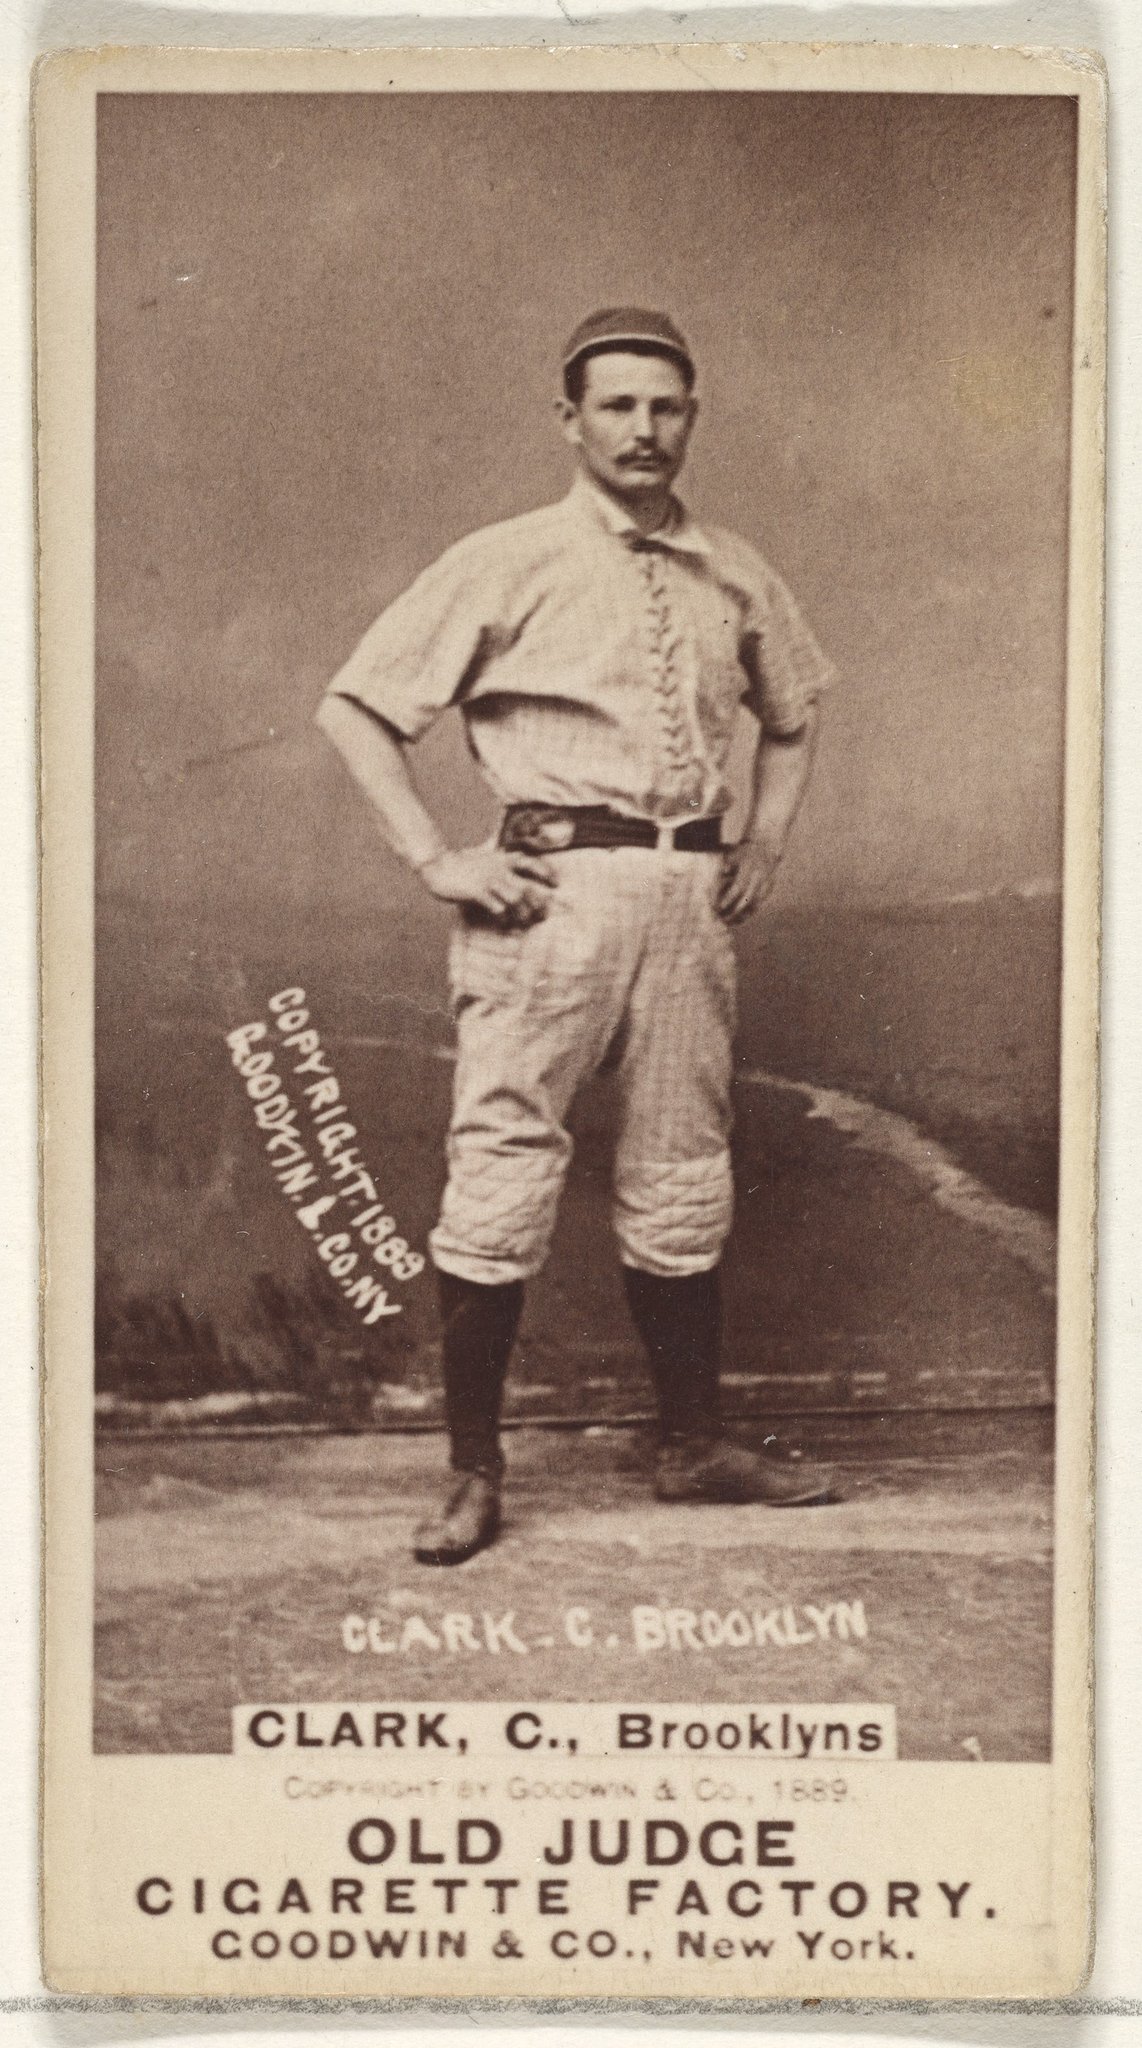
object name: baseball card, photograph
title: Clark, Catcher, Brooklyn, from the Old Judge series (N172) for Old Judge Cigarettes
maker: goodwin & company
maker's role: publisher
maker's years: 1850-1950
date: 1889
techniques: albumen silver print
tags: men,portraits,baseball,athletes